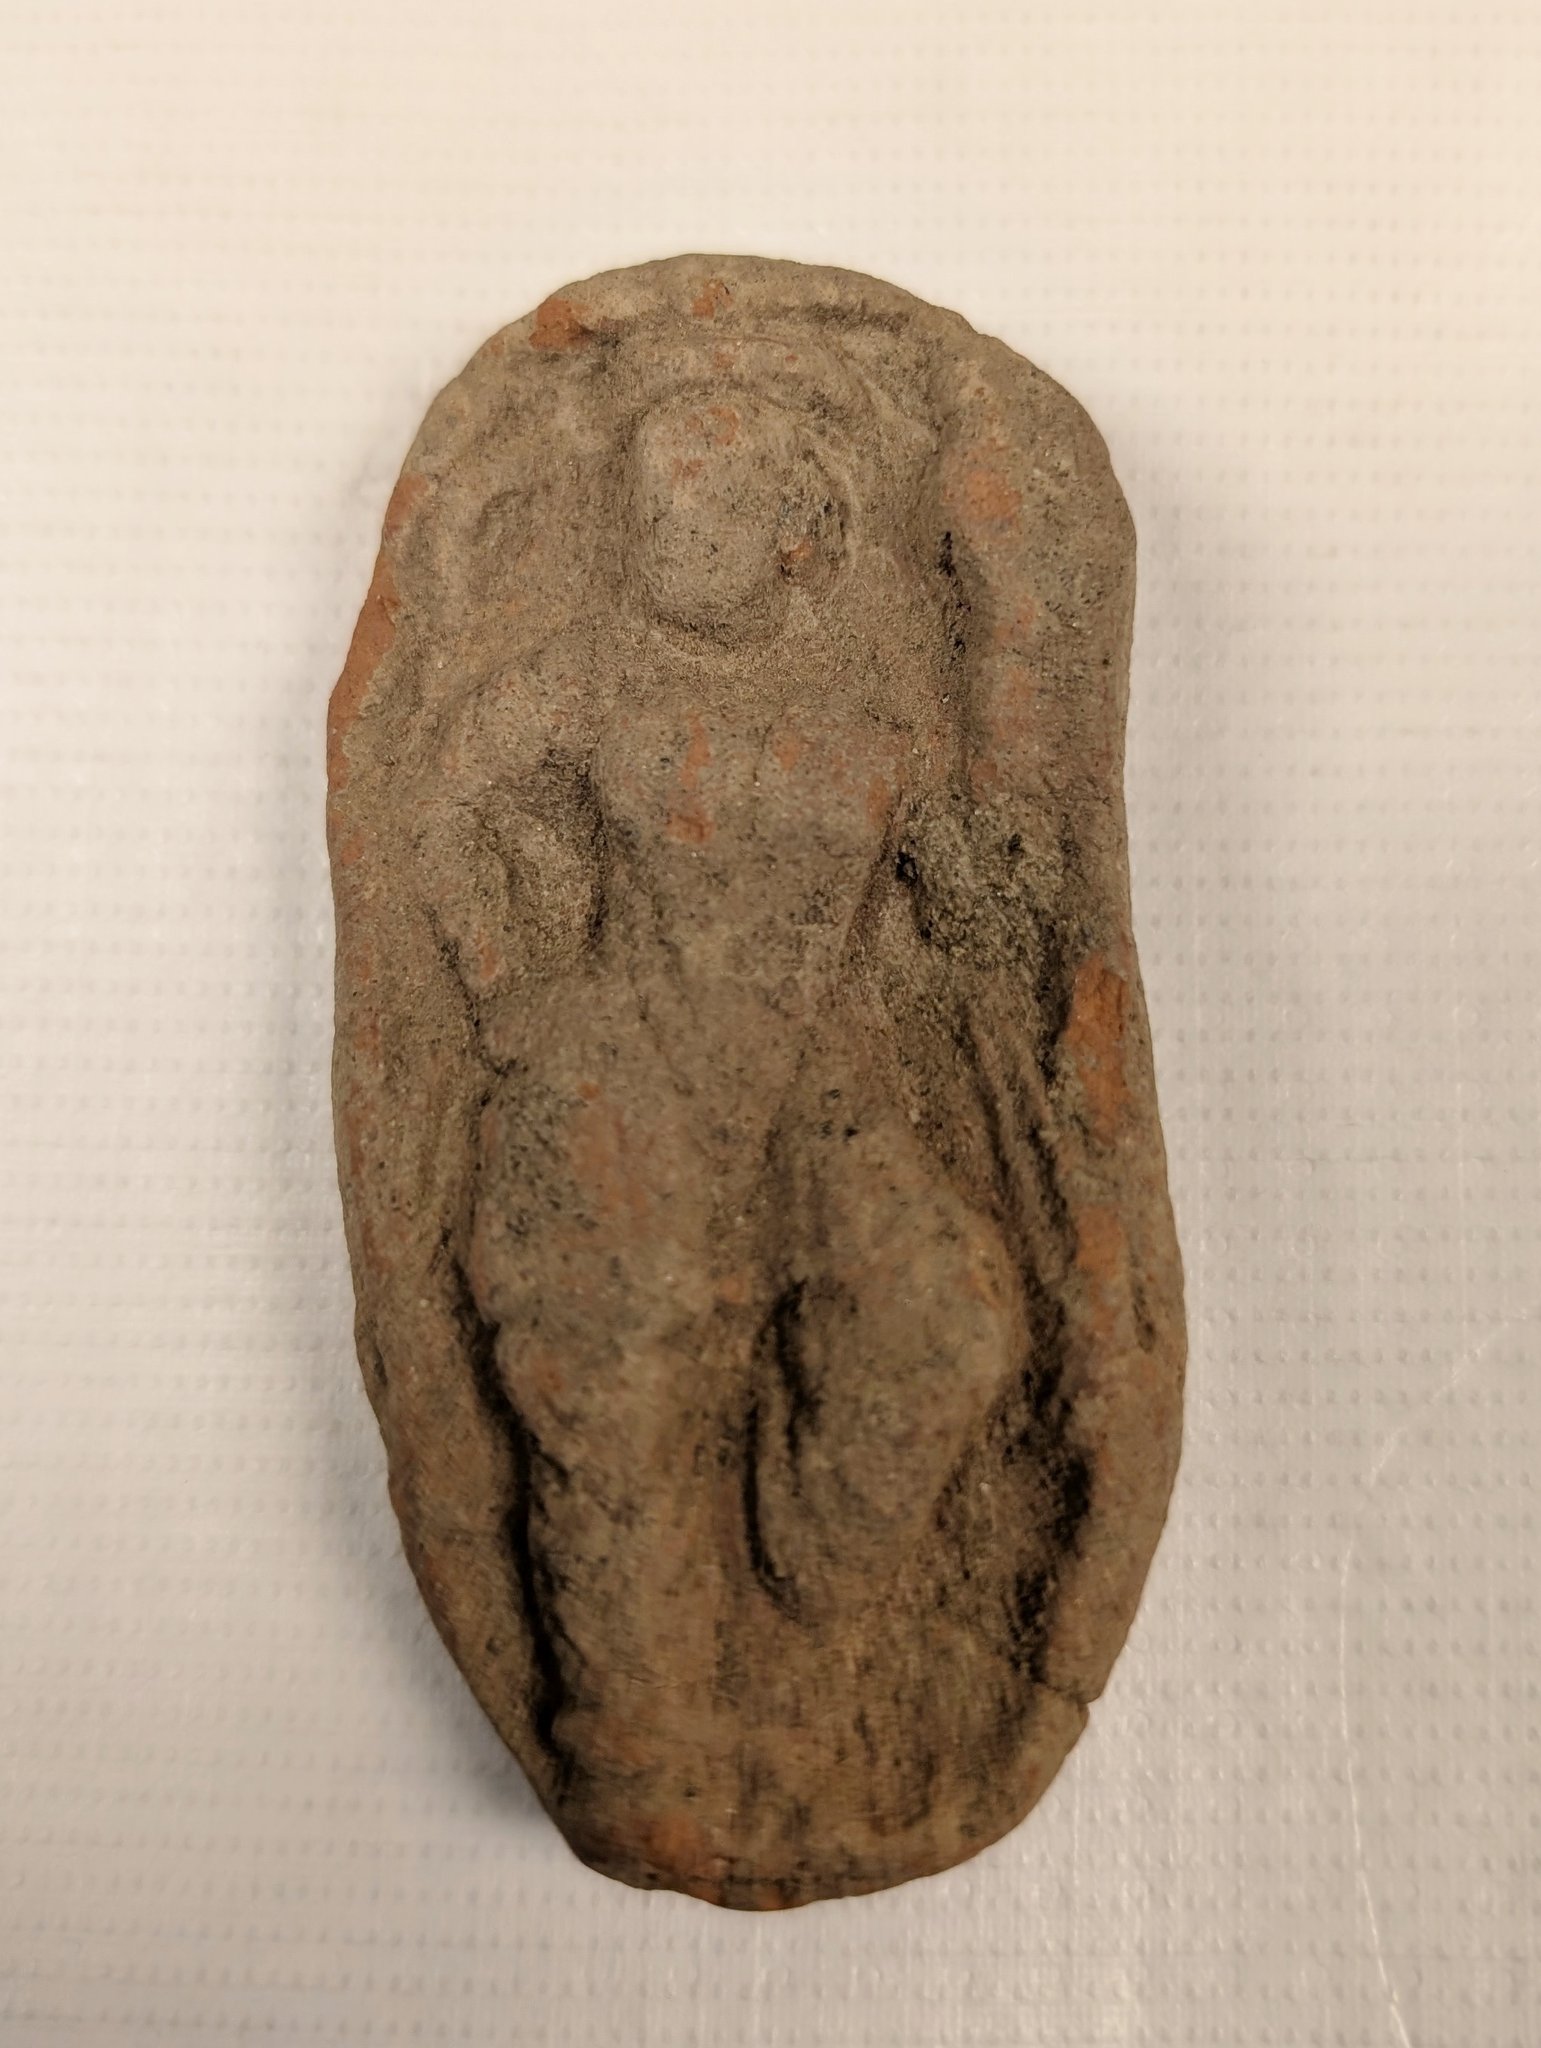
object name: plaque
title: Plaque in the Form of a Female Figure (Study Collection)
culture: pakistani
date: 101-300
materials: terracotta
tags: gandhara